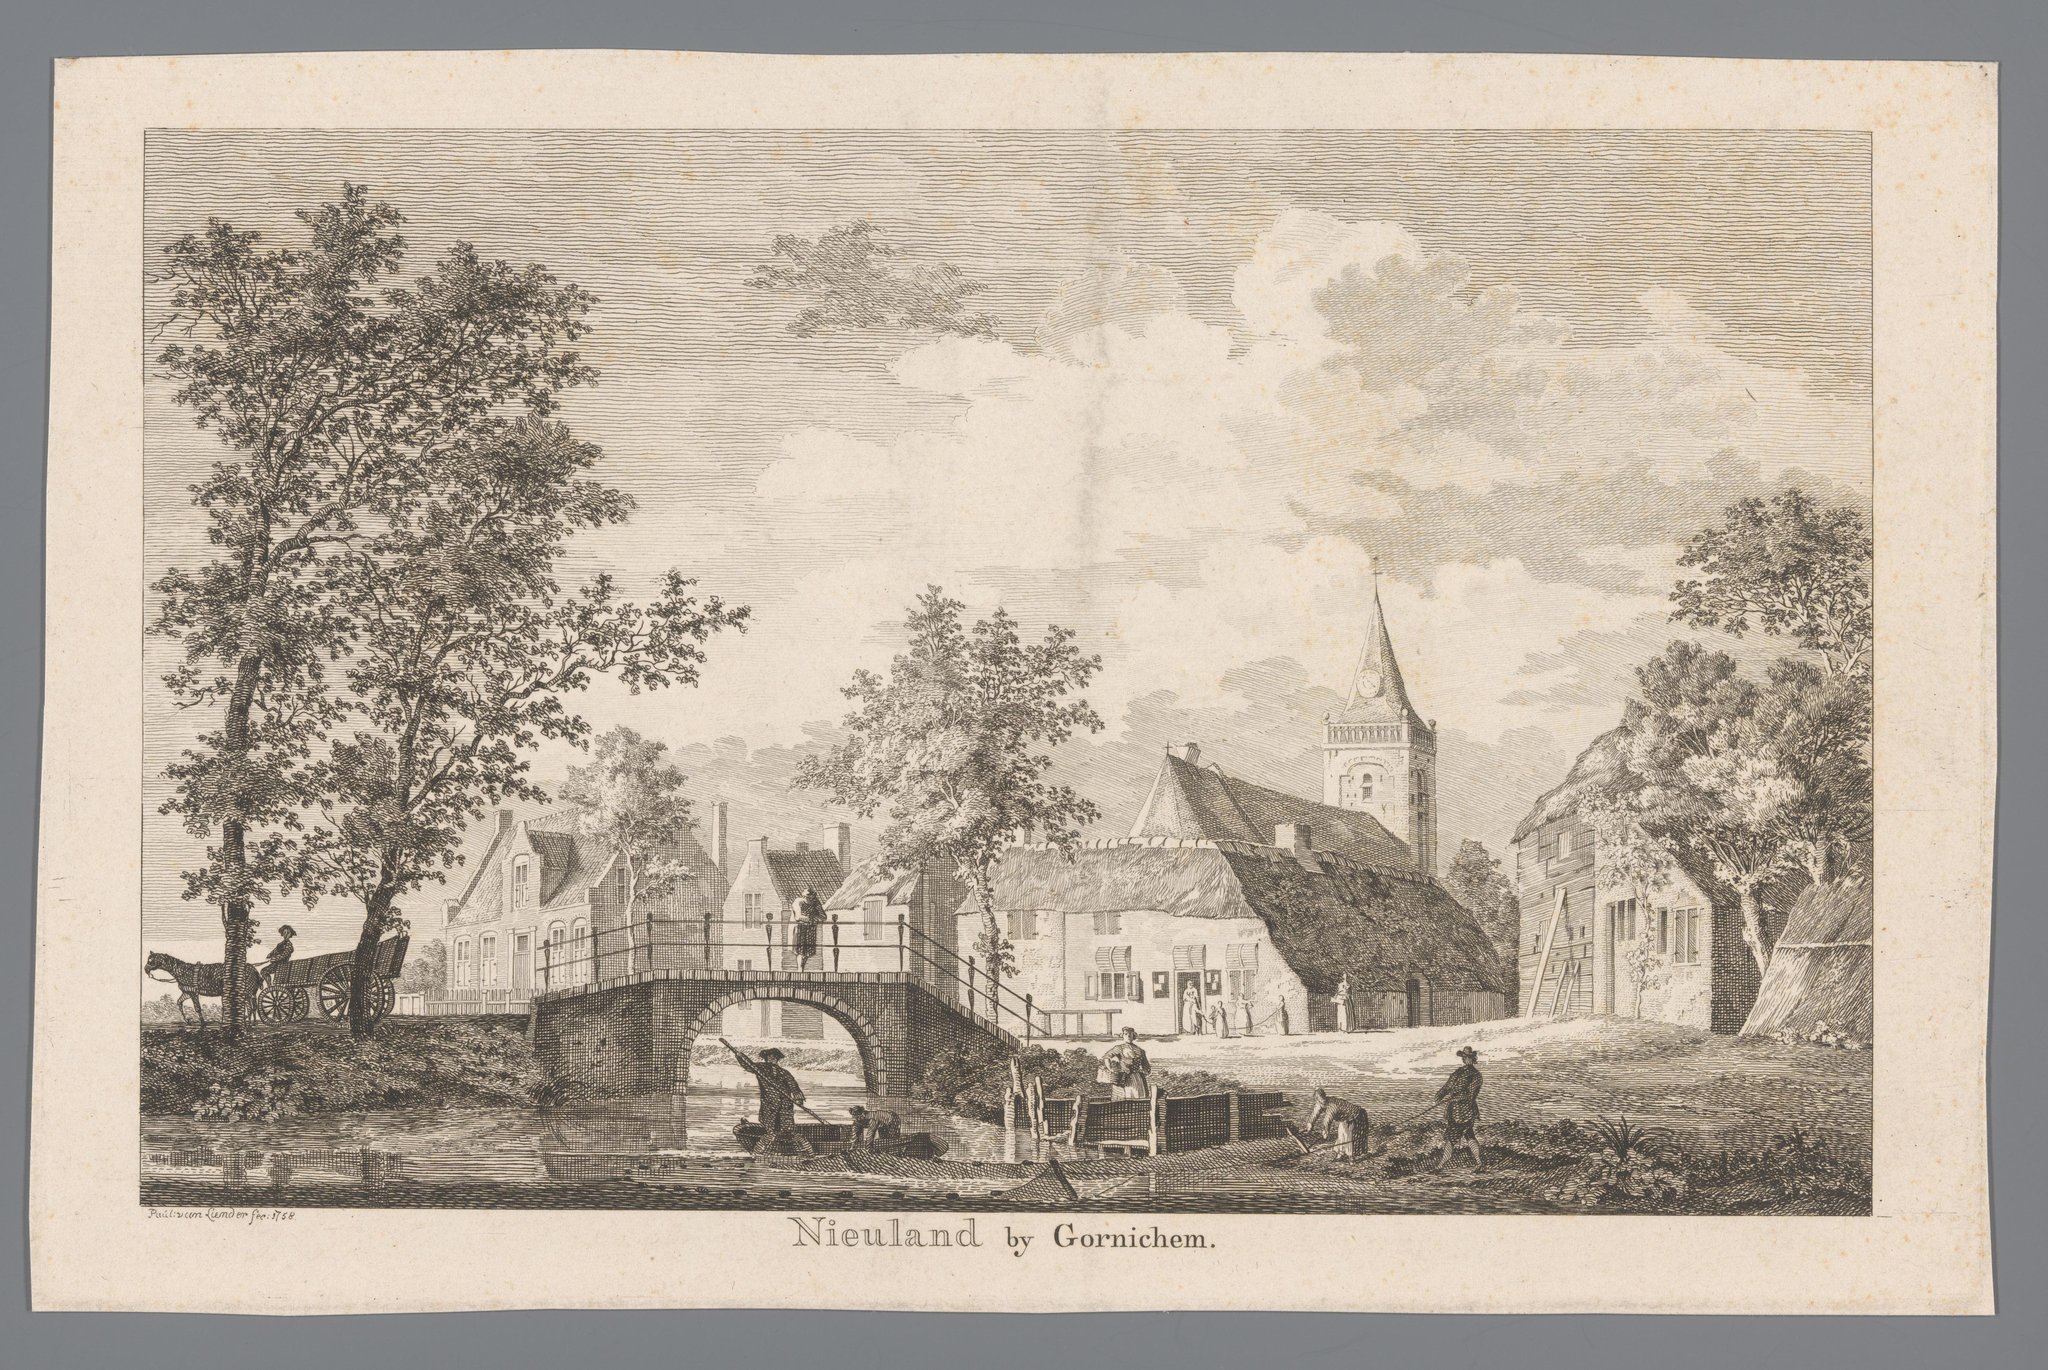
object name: print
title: Nieuland by Gornichem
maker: paulus van liender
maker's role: draughtsman, print maker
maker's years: 1731-1797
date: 1758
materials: paper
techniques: etching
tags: four-wheeled vehicle drawn by one animal, village, poling, punting, bridge in village across river, canal, etc.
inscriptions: date